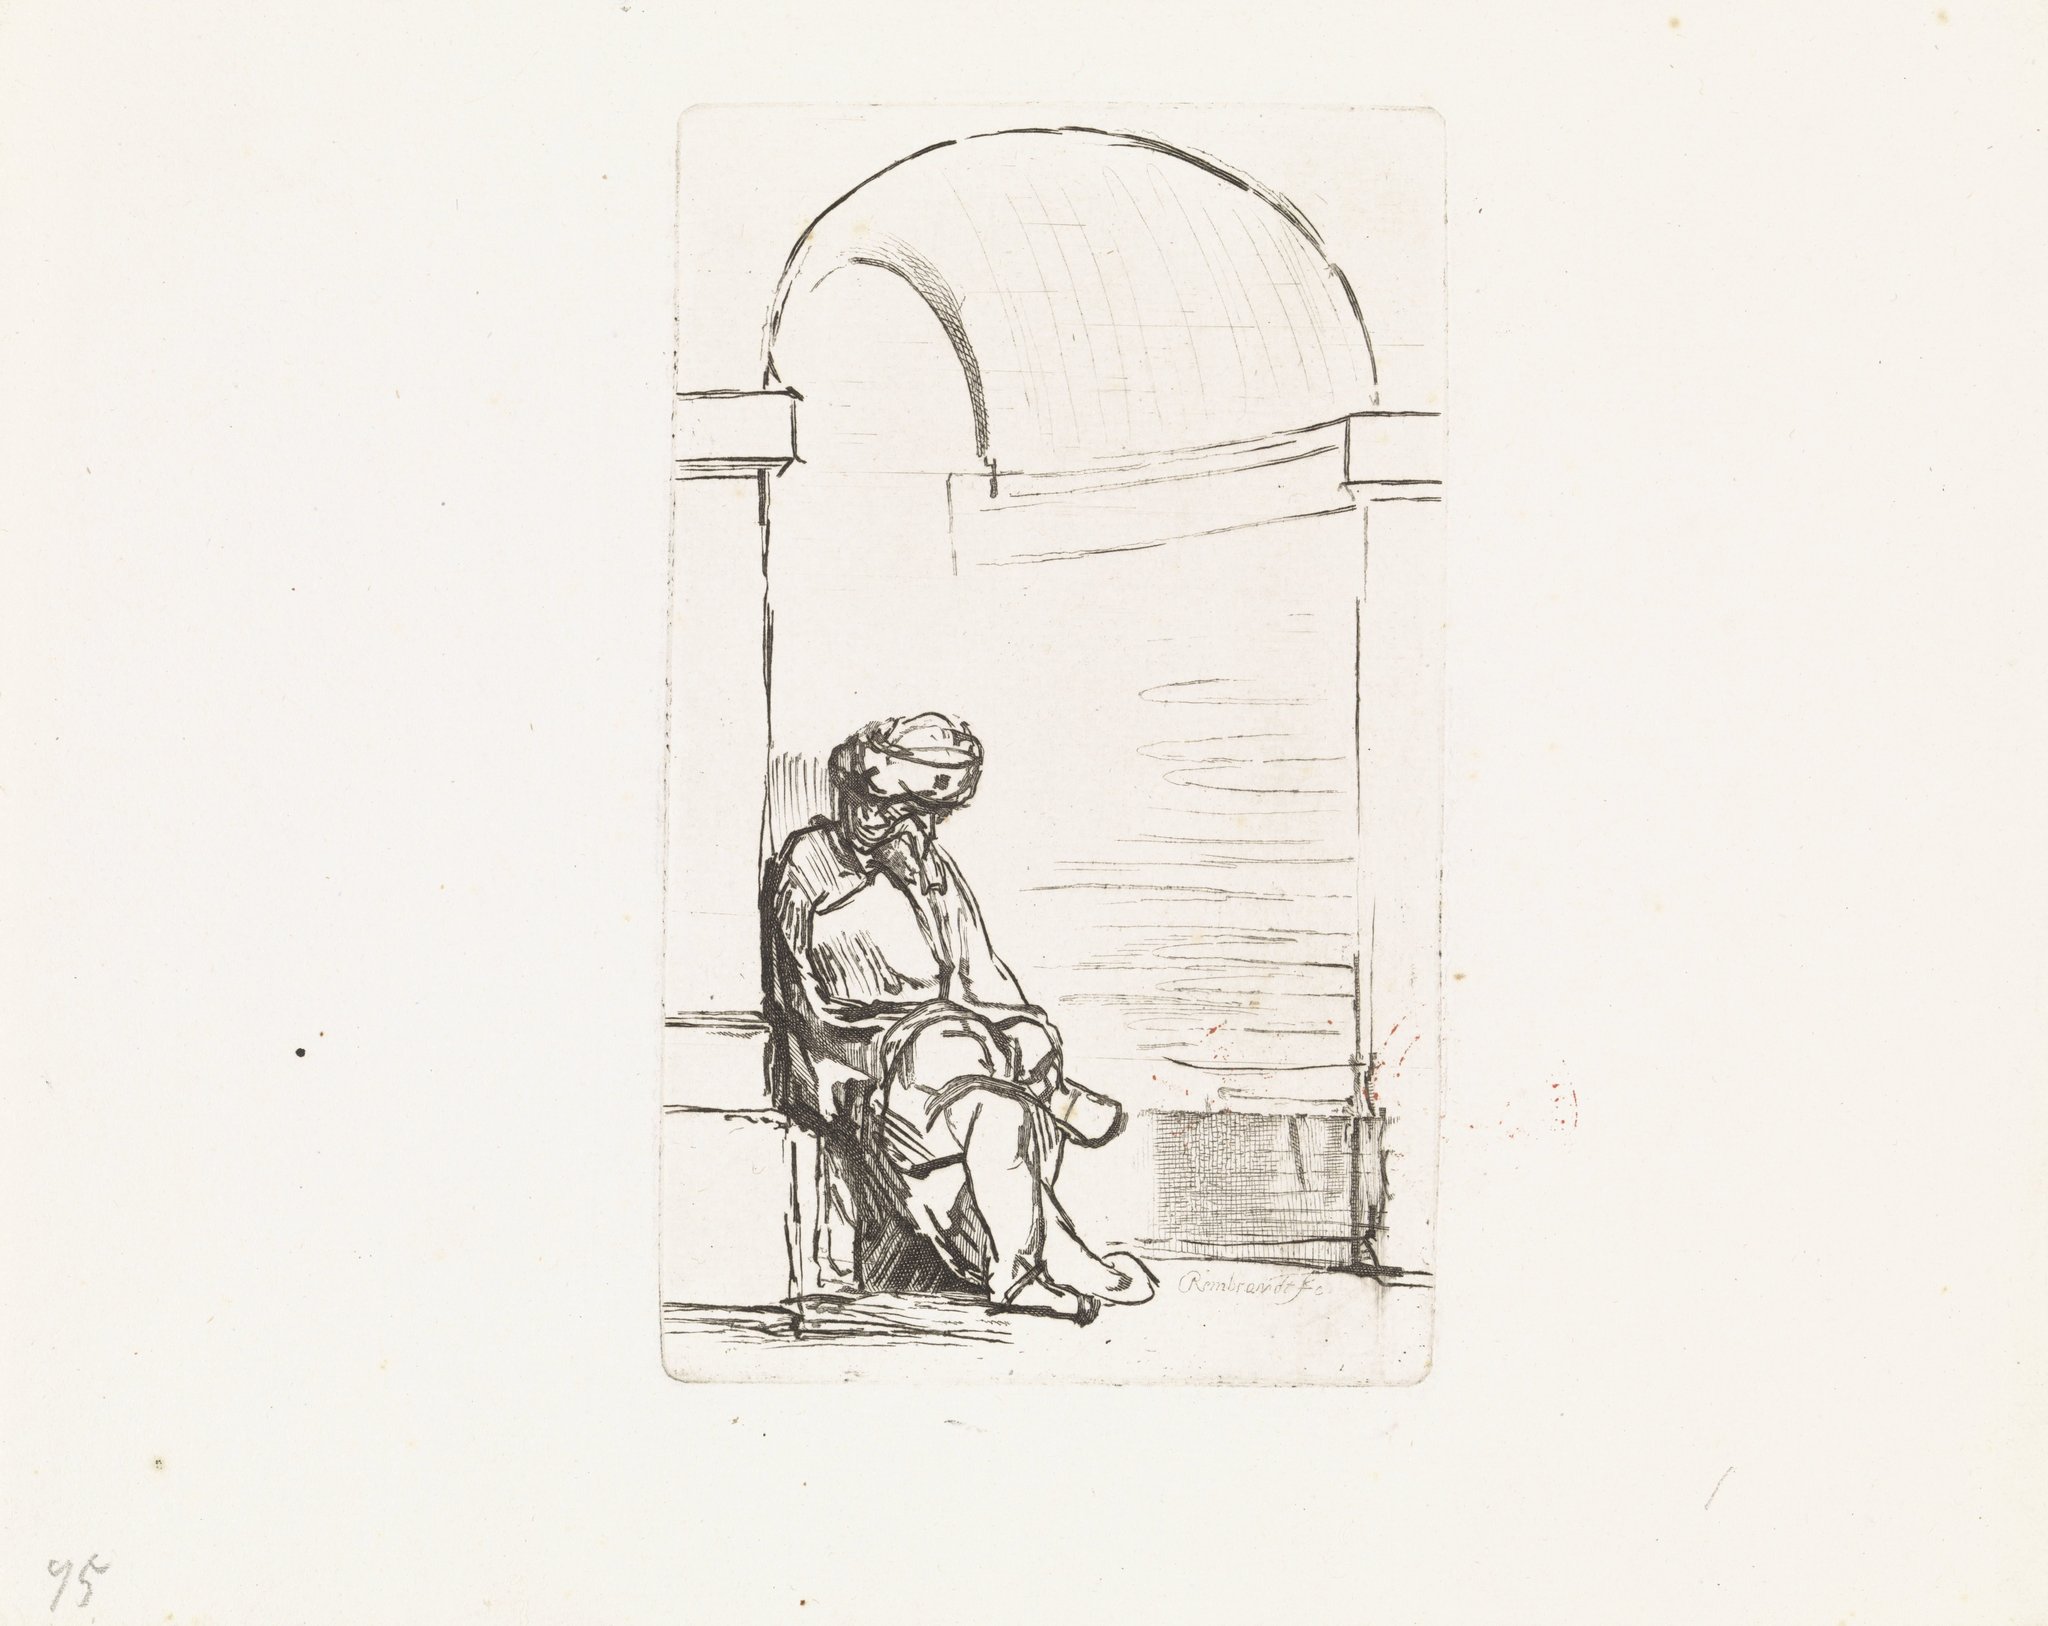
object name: print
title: Verscheide gedagten in het koper gebragt naar de origenelen teekeningen en schetschen van Rembrandt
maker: matthijs pool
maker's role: print maker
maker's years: 1676-1740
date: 1696-1727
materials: paper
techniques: engraving, etching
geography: amsterdam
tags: head-gear: turban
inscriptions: collector's mark: Lugt 240